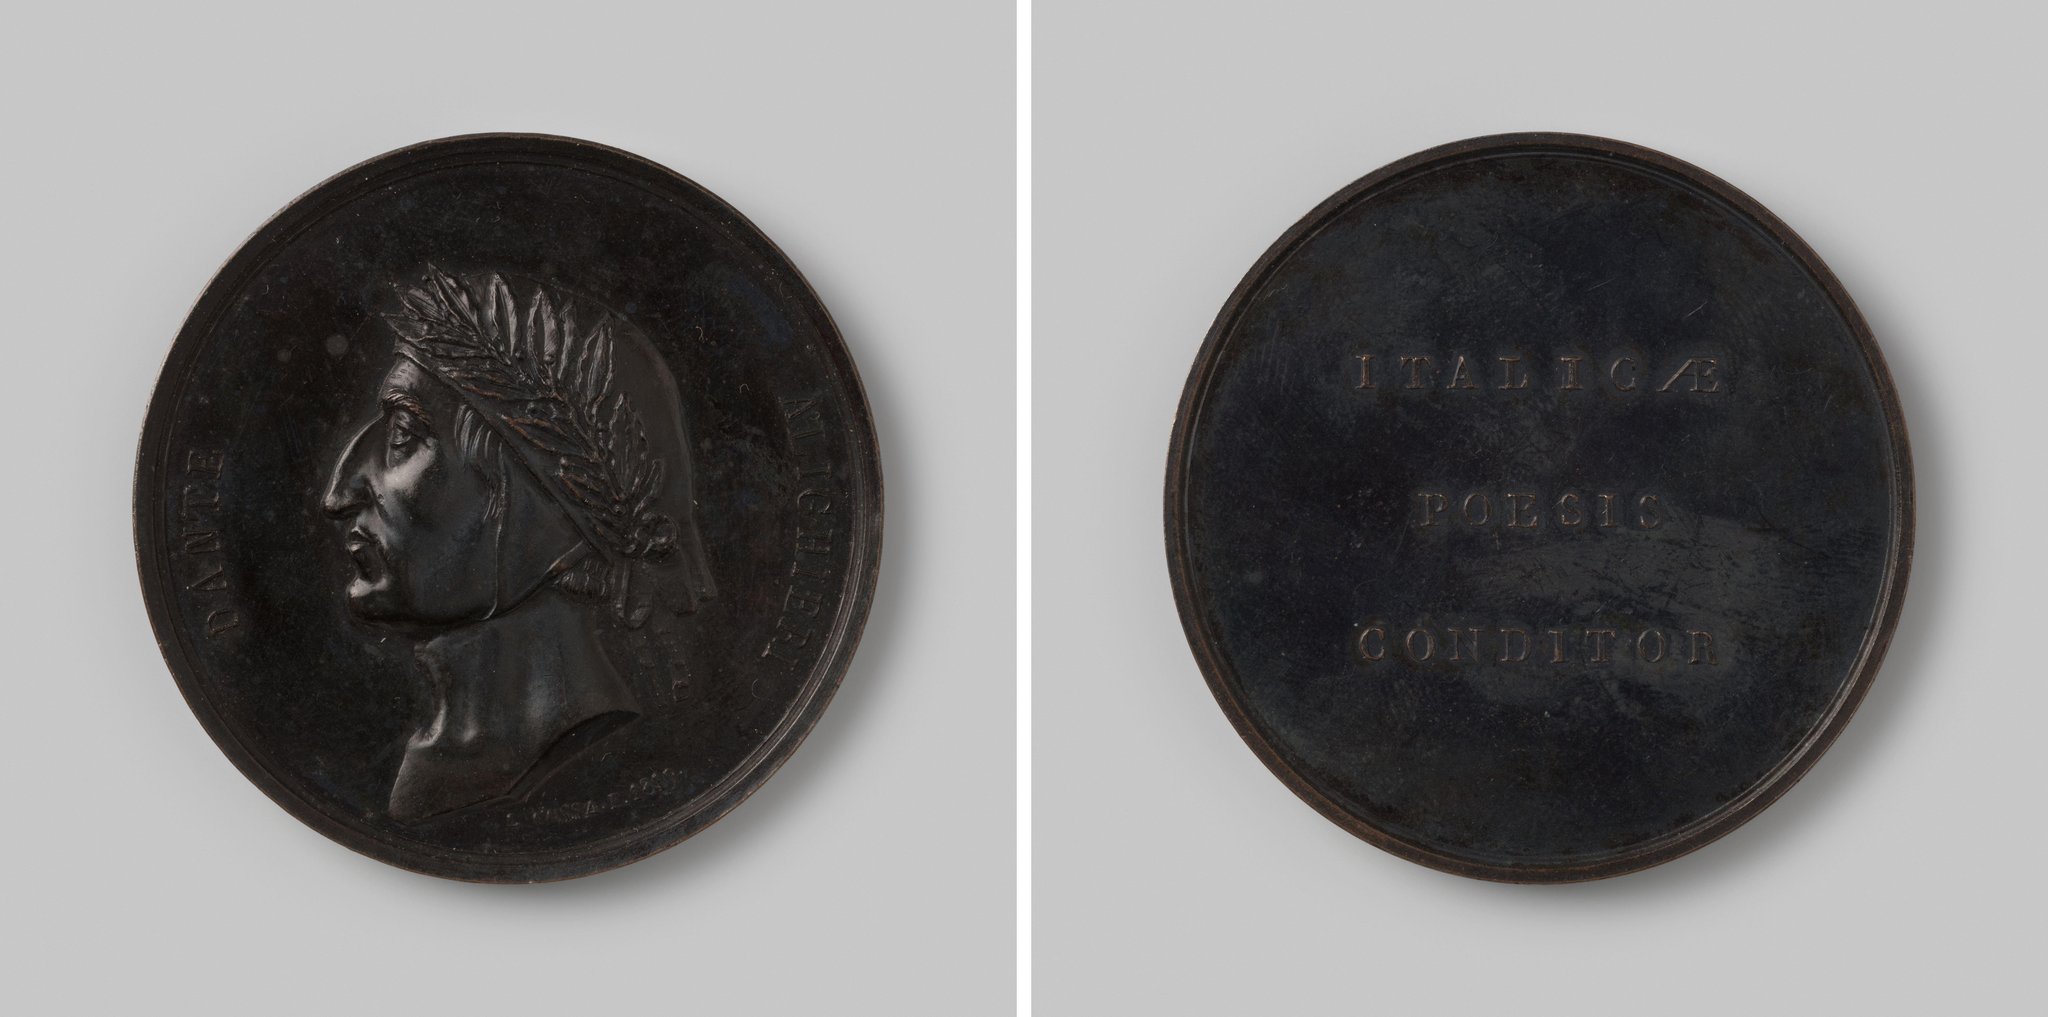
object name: history medal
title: Dante Alighieri (1819)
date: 1819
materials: bronze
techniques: casting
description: Bronzen penning, op de voorzijde het portret van Dante naar links met omschrift, op de keerzijde drie regels tekst.